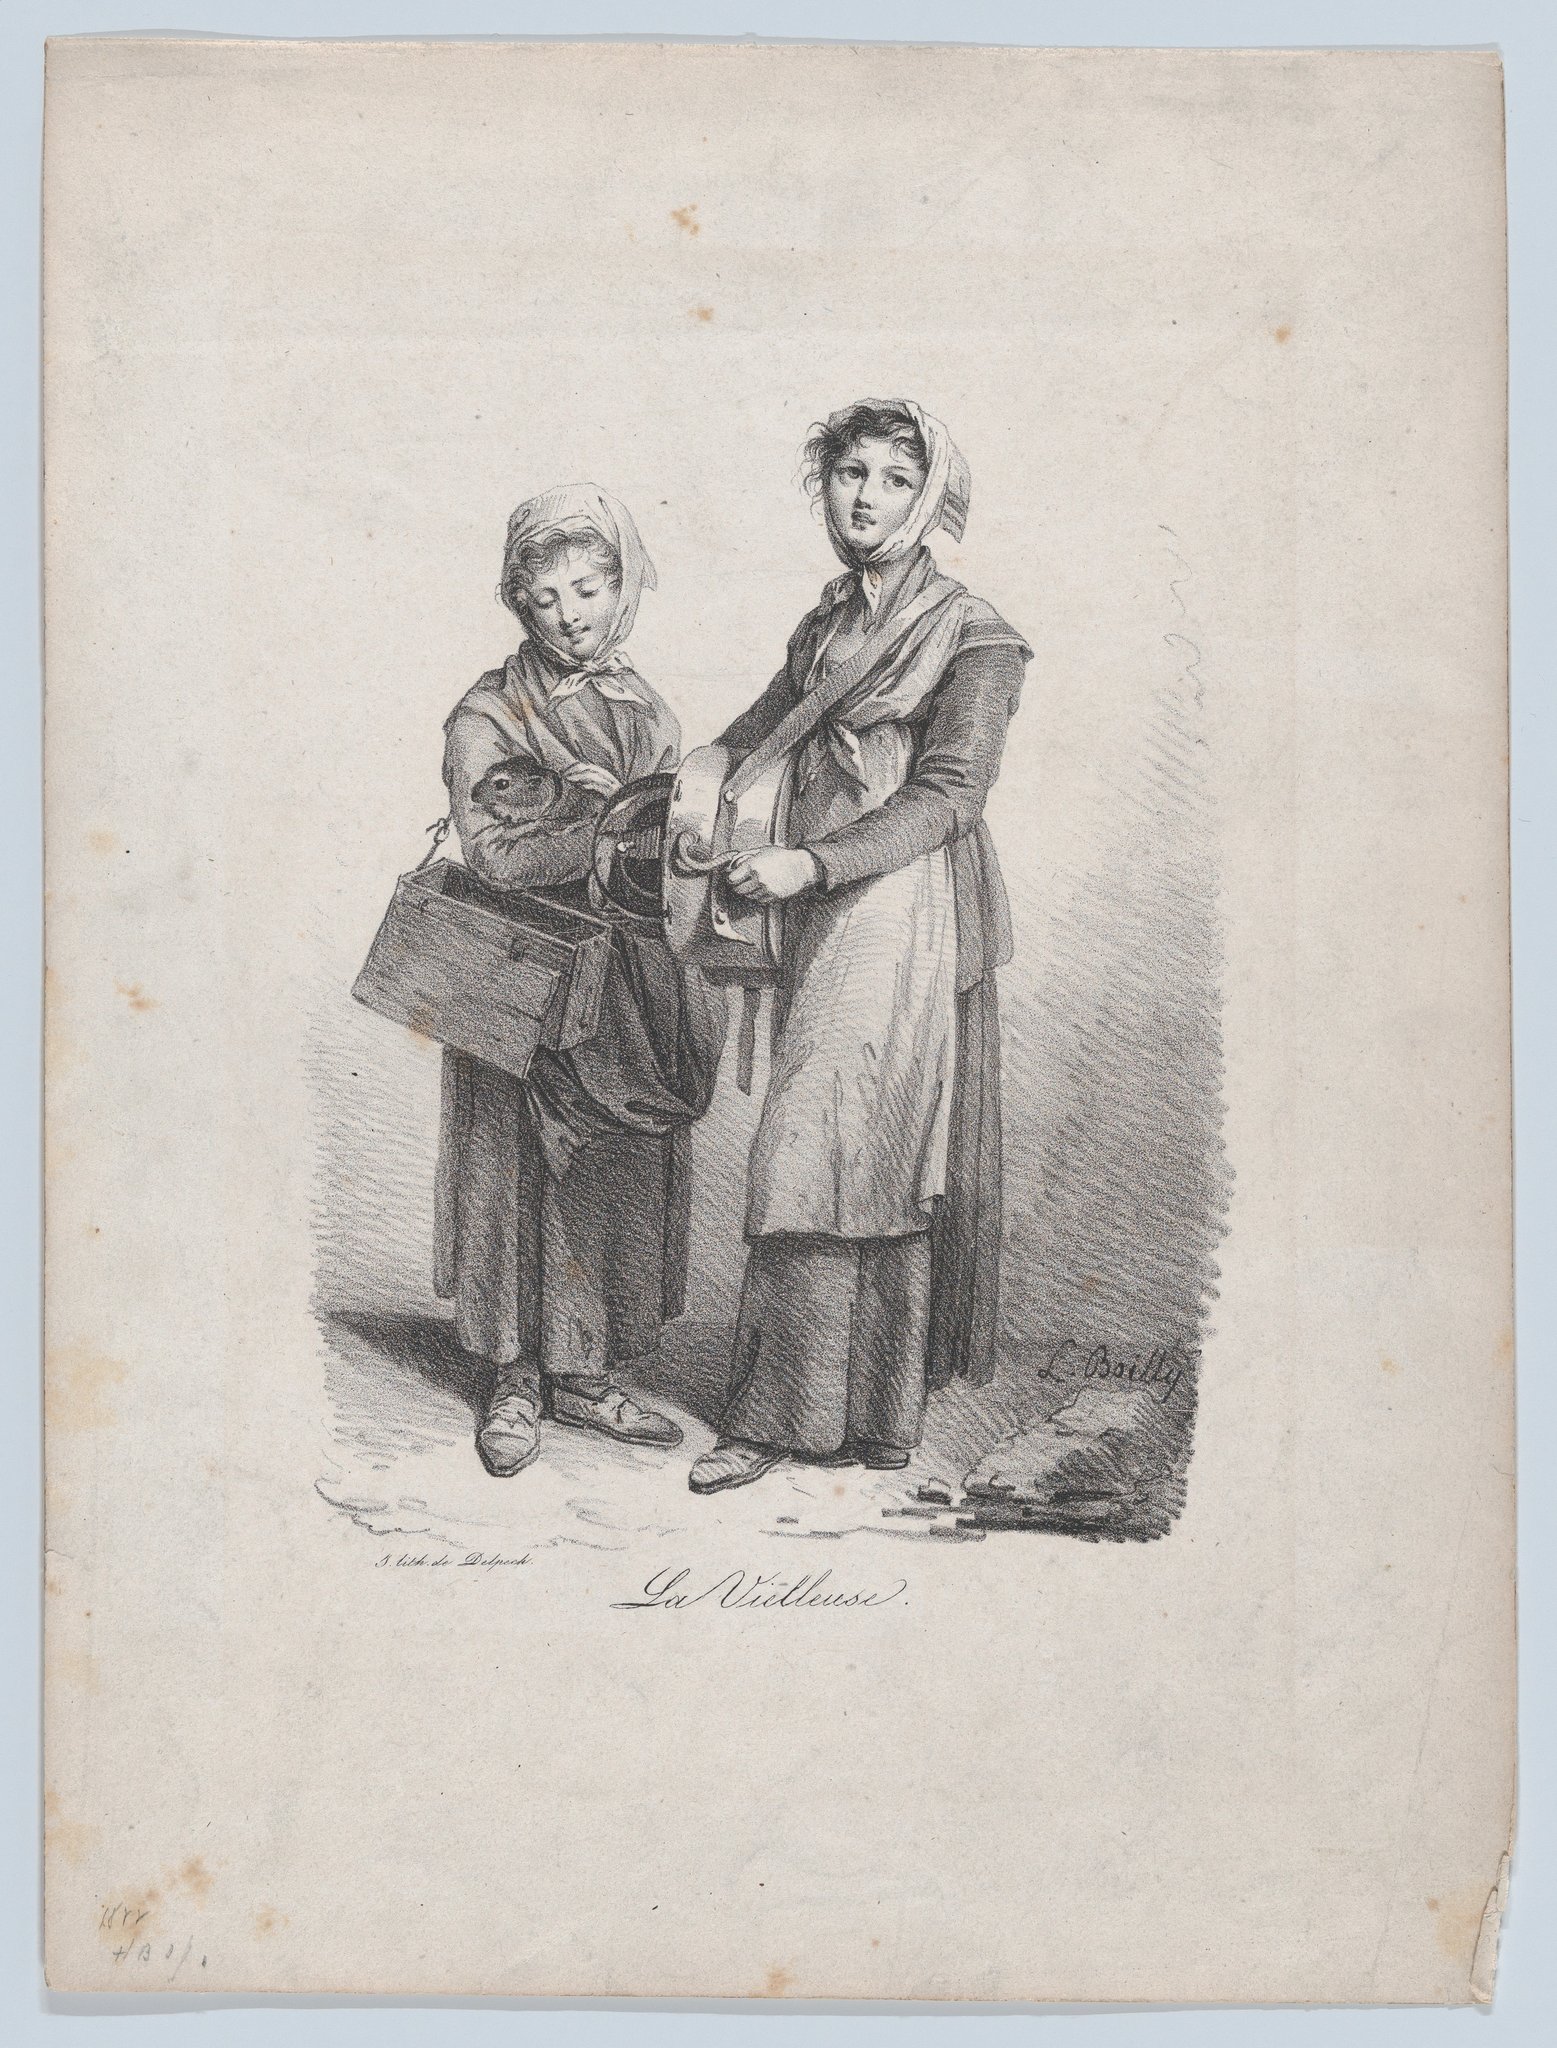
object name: print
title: The Hurdy-Gurdy Player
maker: louis léopold boilly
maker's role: artist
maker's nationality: french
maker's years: 1761-1845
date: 1822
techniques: lithograph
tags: musical instruments,animals,women,music